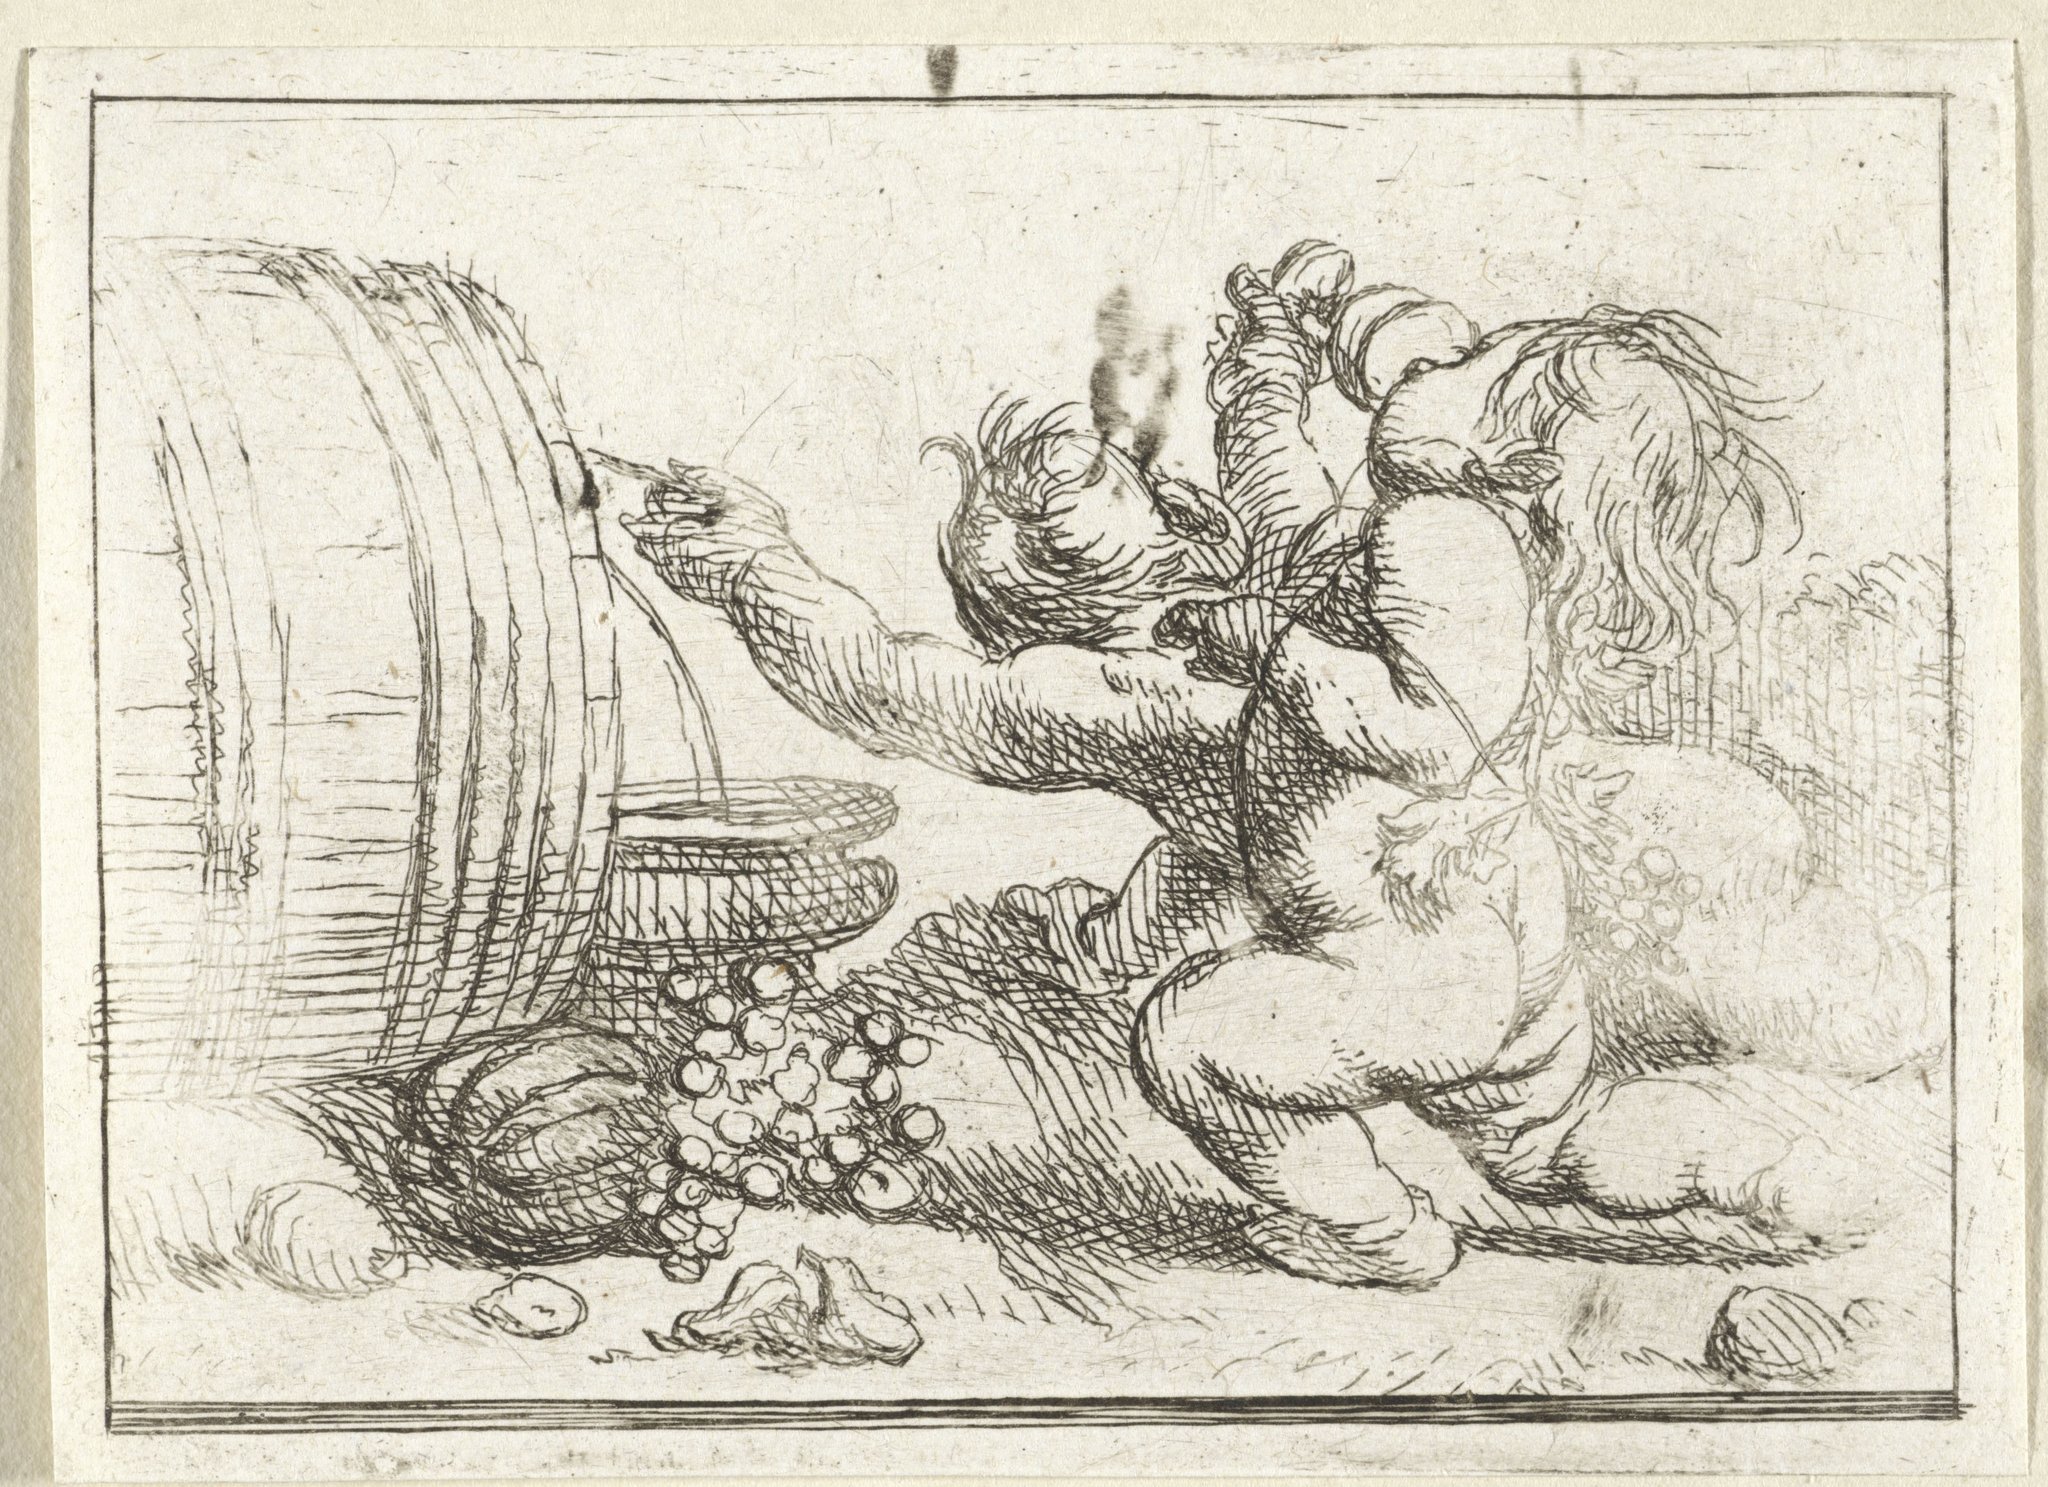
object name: print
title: Twee kinderen bij een wijnvat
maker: cornelis schut (i)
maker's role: draughtsman, print maker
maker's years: 1597-1655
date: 1618-1655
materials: paper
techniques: engraving, etching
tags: wooden container: barrel, cask, bucket, children's bacchanal, glass of wine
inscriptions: collector's mark: Lugt 240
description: Twee kinderen doen zich tegoed aan wijn die ze uit een vat tappen.